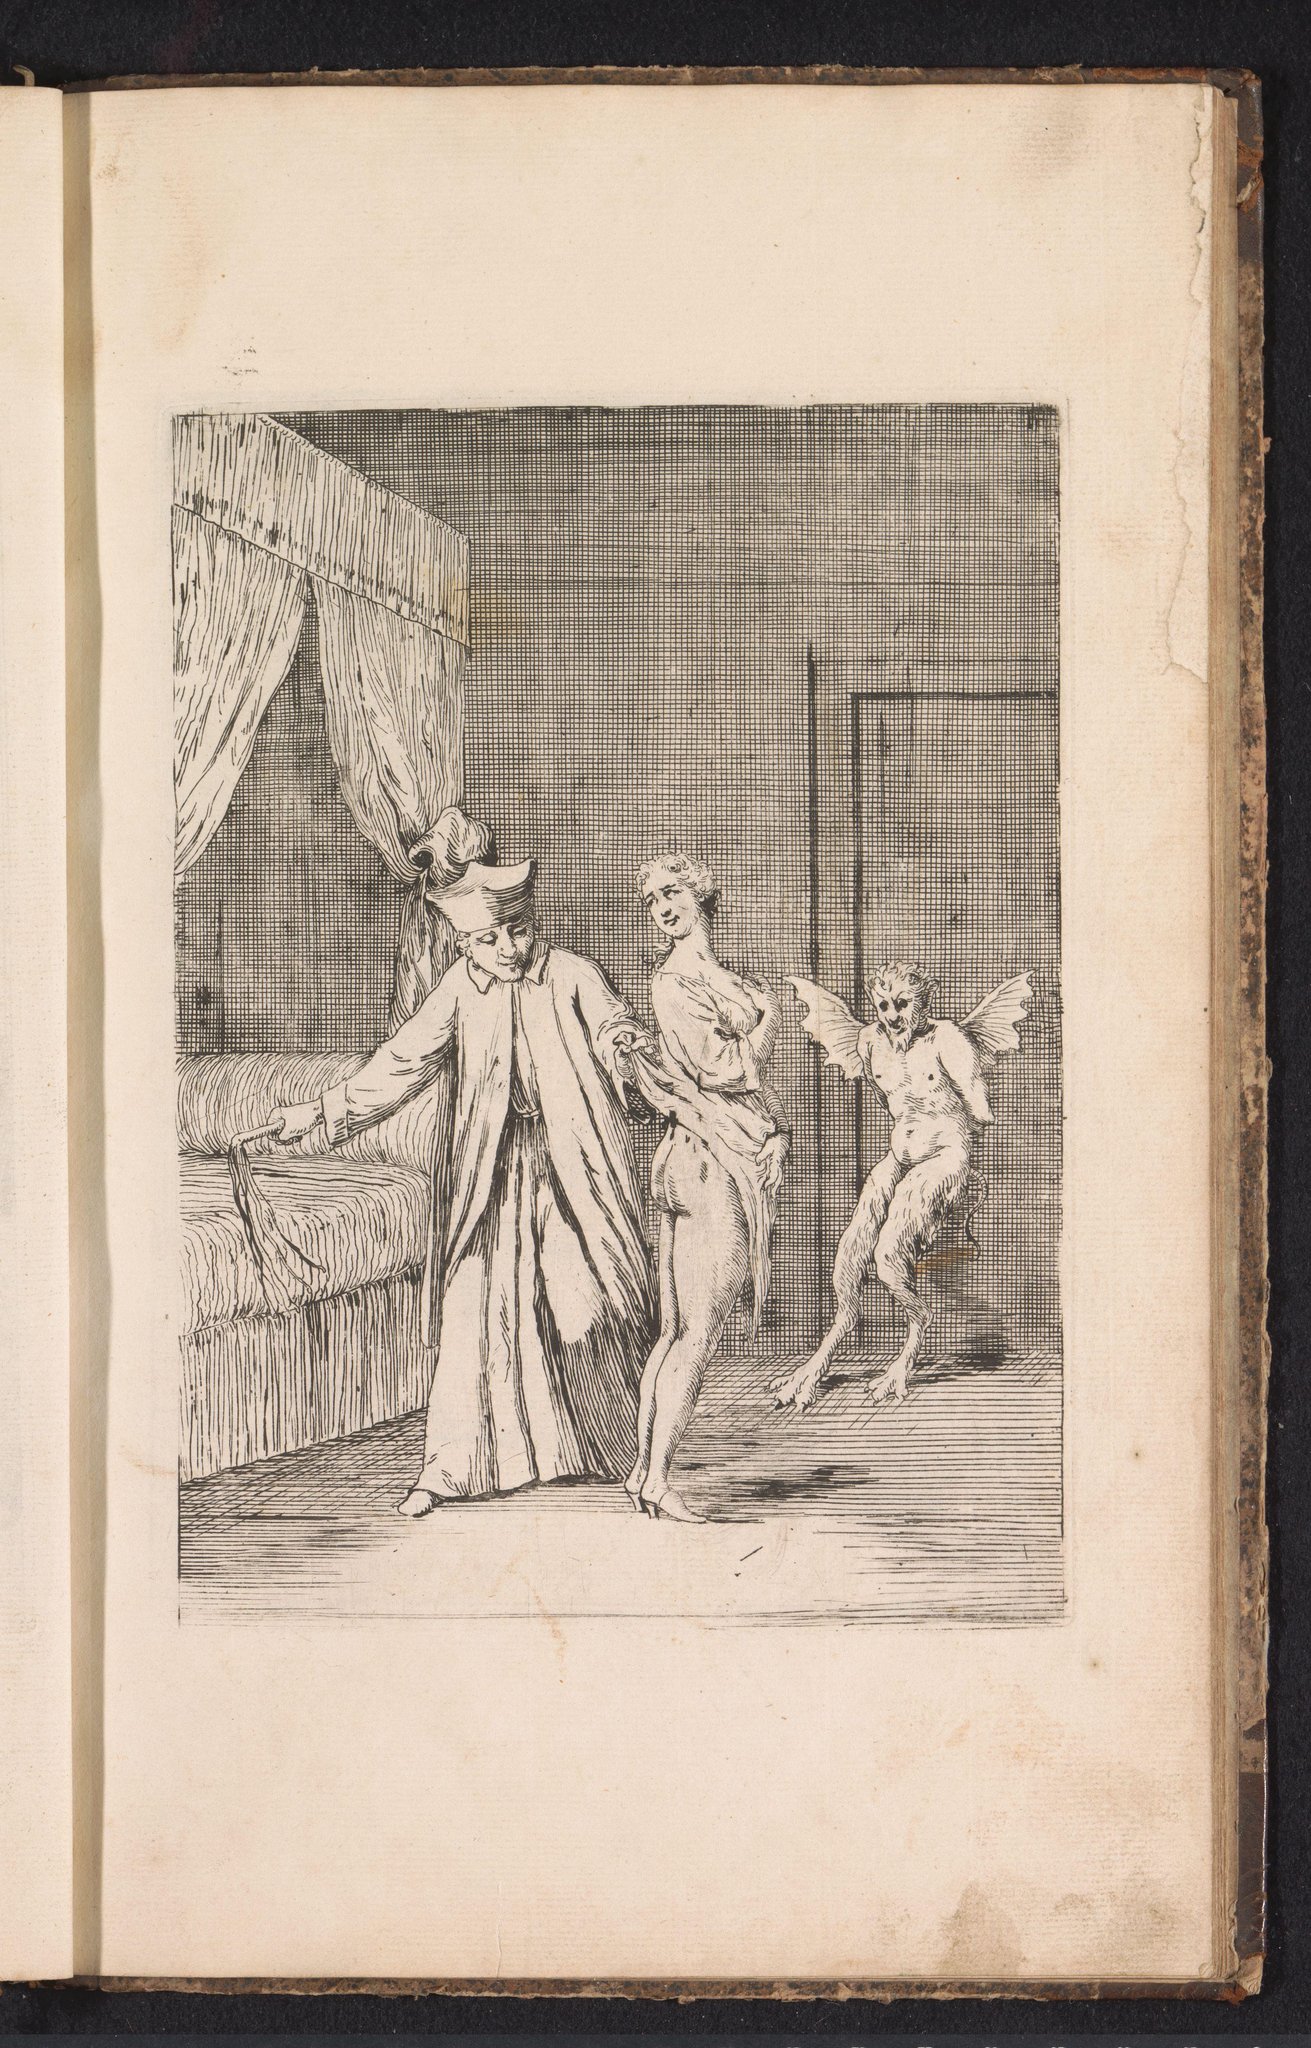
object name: print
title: Tableaux De l'Histoire Du Pere Jean Baptiste Girard & Marie Catherine Cadiere en XXXII Estampes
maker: jacques gabriel huquier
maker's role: draughtsman, painter, print maker, publisher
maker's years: 1725-1805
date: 1735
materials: paper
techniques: etching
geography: france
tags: toulon, witch, sorcerer with the devil and/or demons, sexual abuses of monks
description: De naakte Marie-Catherine Cadière wordt door Jean-Baptiste Girard gegeseld. Onderdeel van de reeks van 32, veelal erotisch getinte, prenten gewijd aan het schandaal rond Marie-Catherine Cadière en de Jezuïet Jean-Baptiste Girard in 1730-1731.